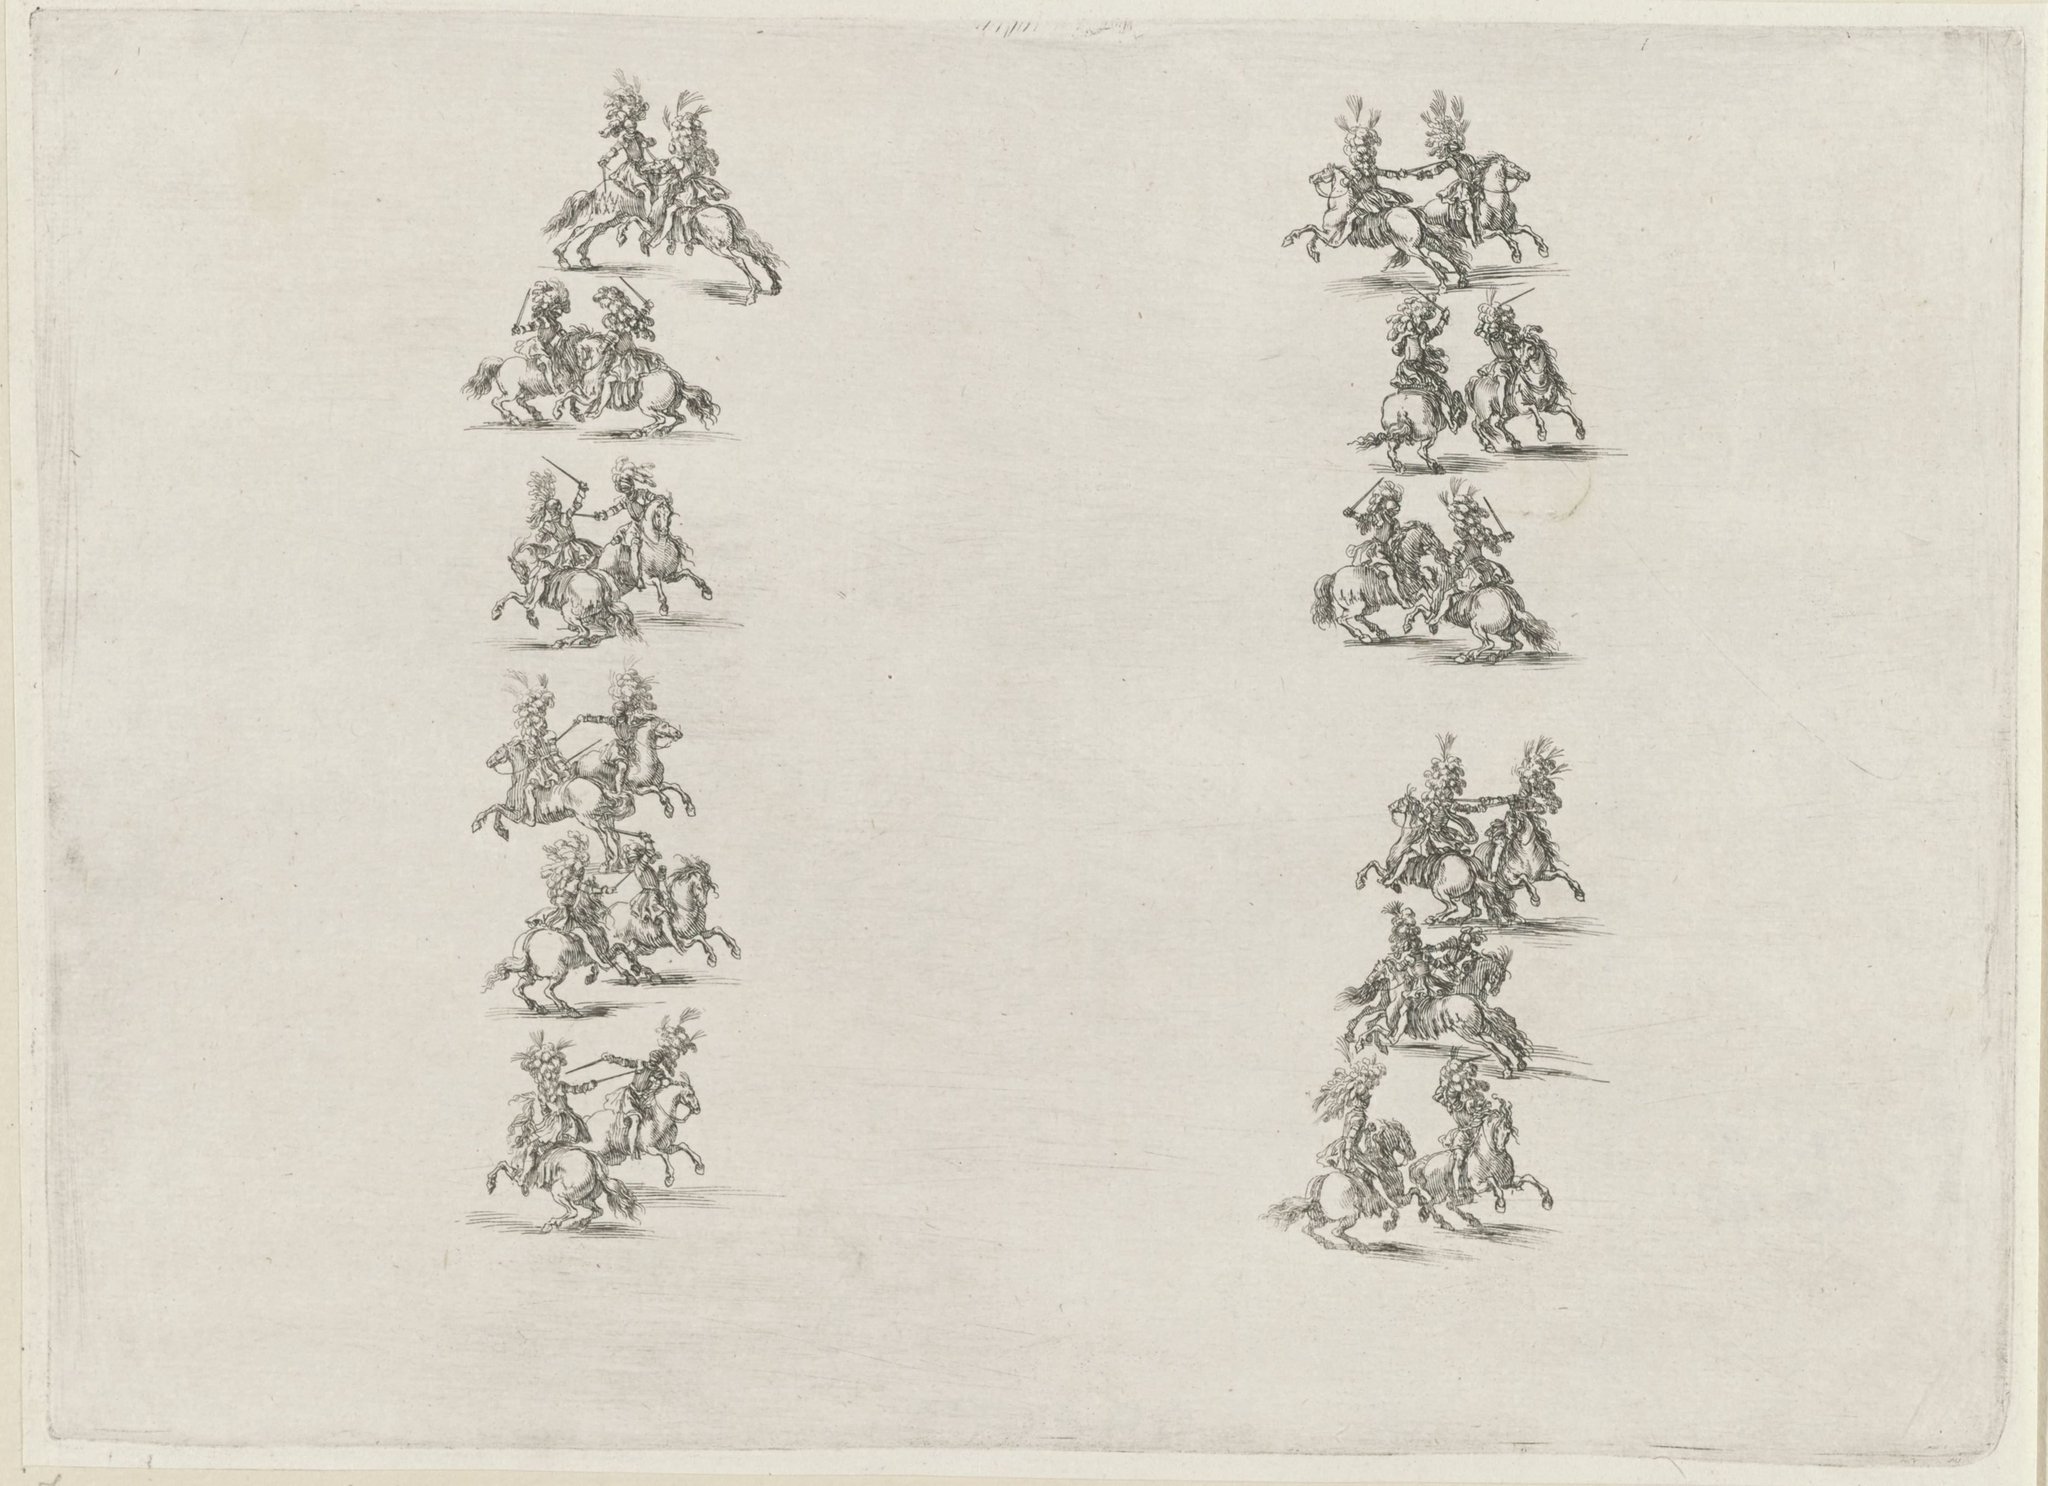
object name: ornament print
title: Vierentwintig ruiters te paard in twee rijen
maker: stefano della bella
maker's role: draughtsman, print maker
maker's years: 1610-1664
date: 1652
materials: paper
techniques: etching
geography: italy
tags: riding a horse, ass, or mule; rider, horseman, festivities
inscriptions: collector's mark: Lugt 240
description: Reeks van 14 prenten met voorstellingen van een carroussel ter ere van het bezoek van Aartshertogen Ferdinand Karl en Sigmund Franz en Aartshertogin Anna van Oostenrijk in Modena op 10 april 1652. Deze prenten zijn gebruikt als illustratie in 'La gara delle Stagioni, torneo a cavallo rappresentato in Modana nel passaggio de Serenissimi Arciduchi Ferdinando Carlo, Sigismondo Francesco d'Austria, et Arciduchessa Anna di Toscana; in Modana, 1652, con 14 figure grandi di Stefano Della Bella', Modena 1652.